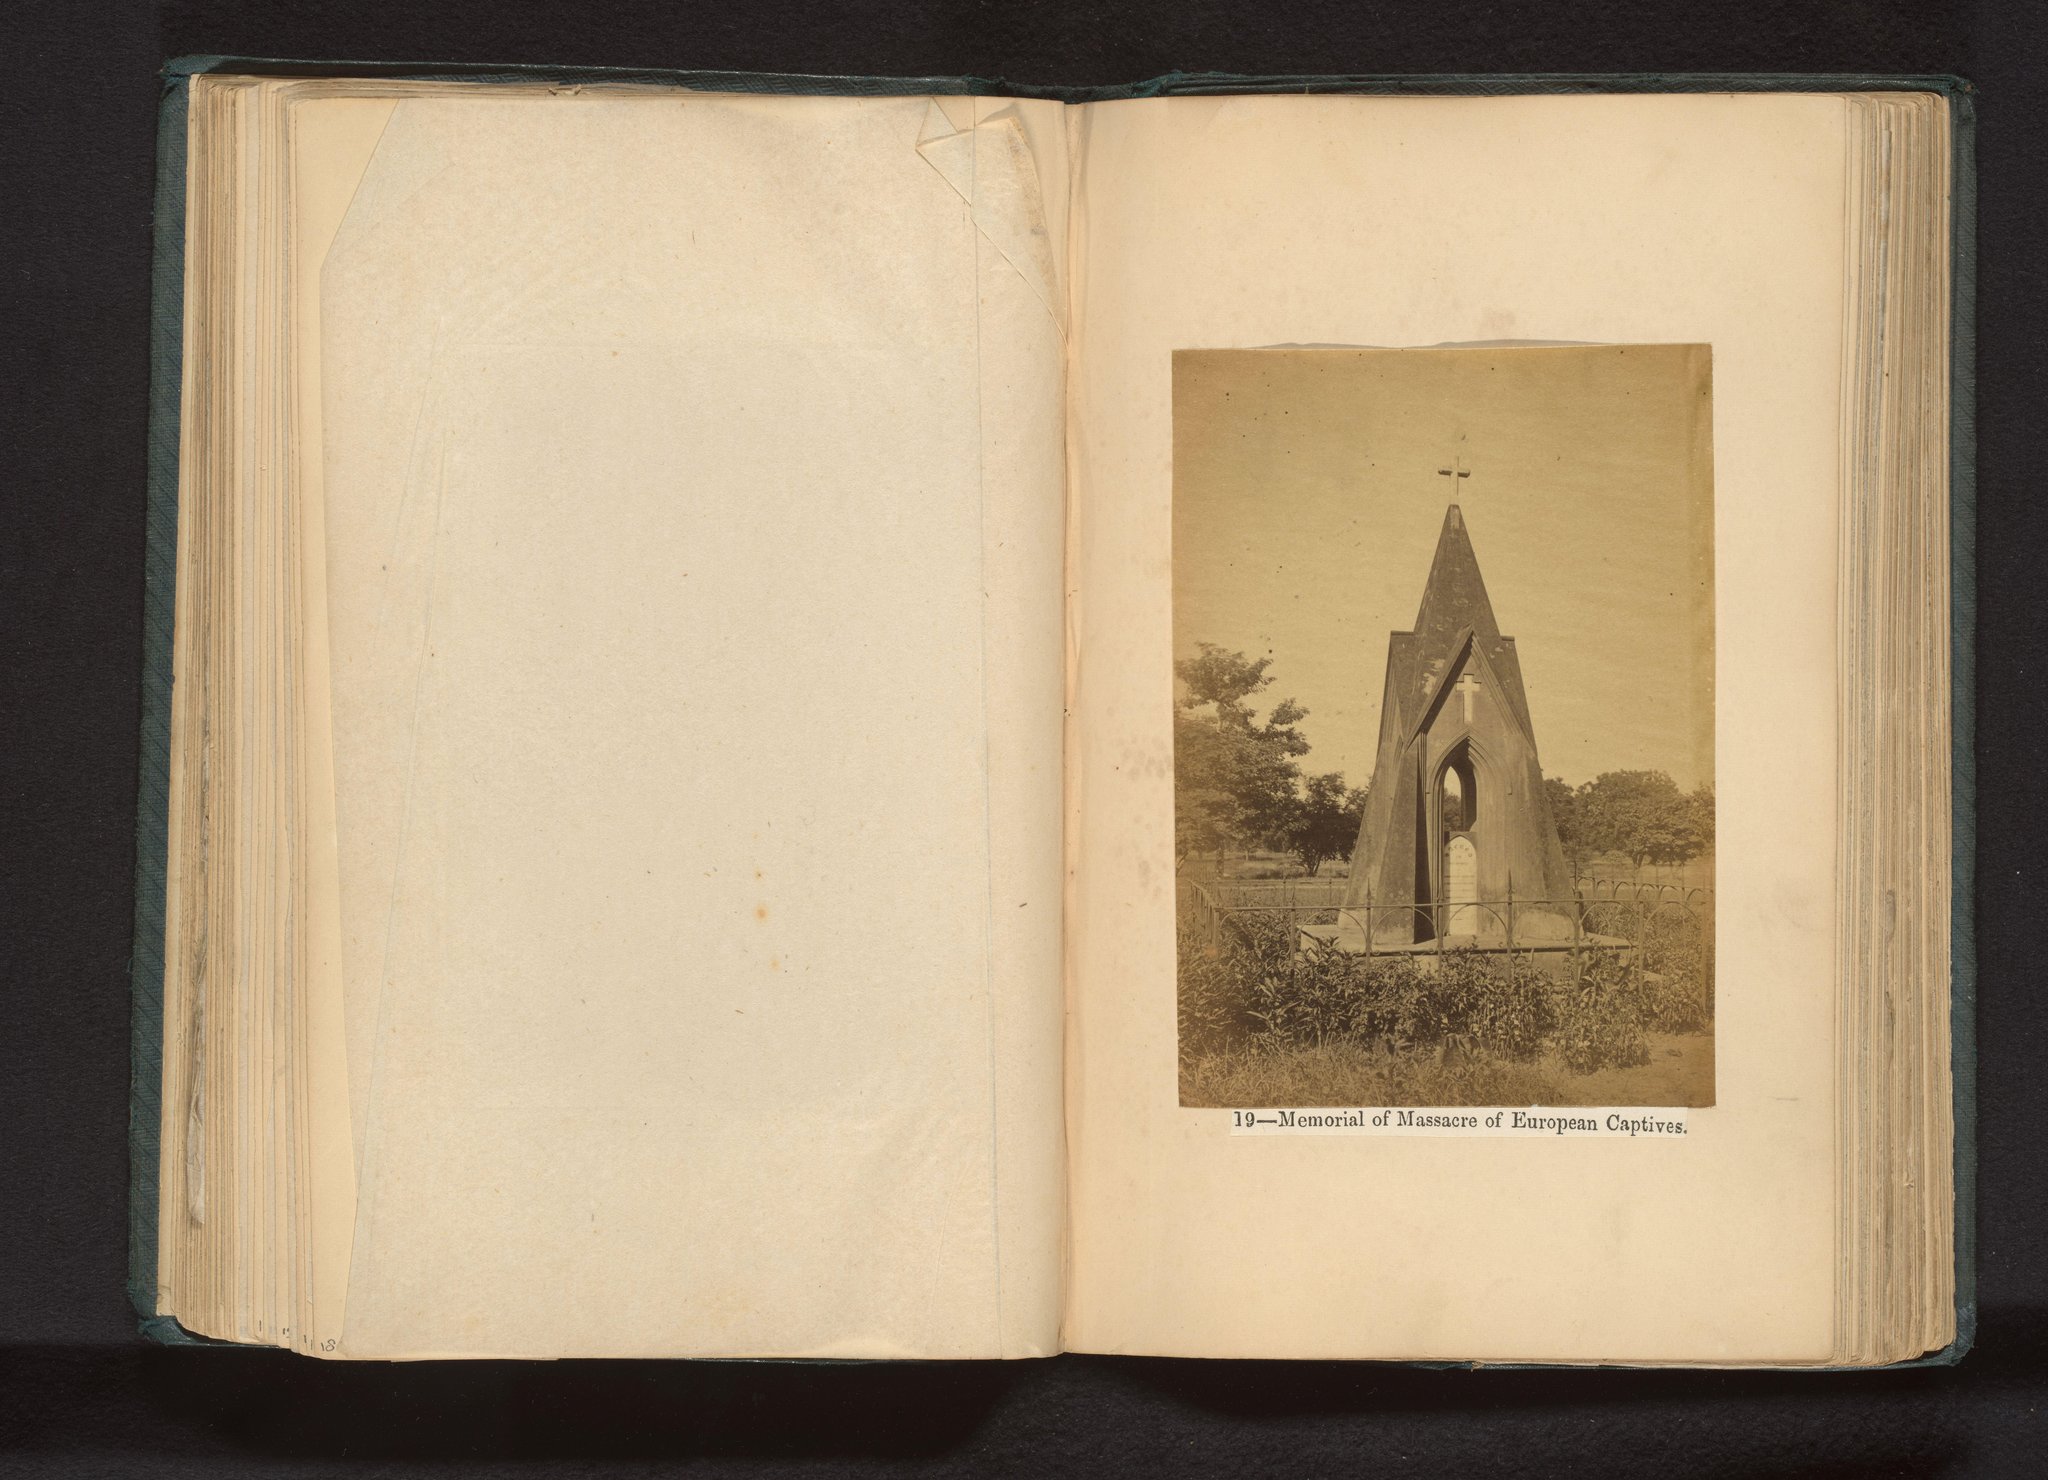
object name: page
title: Monument in Lucknow voor gesneuvelde Europeanen in 1857-1858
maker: darogha ubbas alli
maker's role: fotograaf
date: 1864-1874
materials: photographic support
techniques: albumen print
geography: lucknow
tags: monument, statue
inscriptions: number: ‘19’